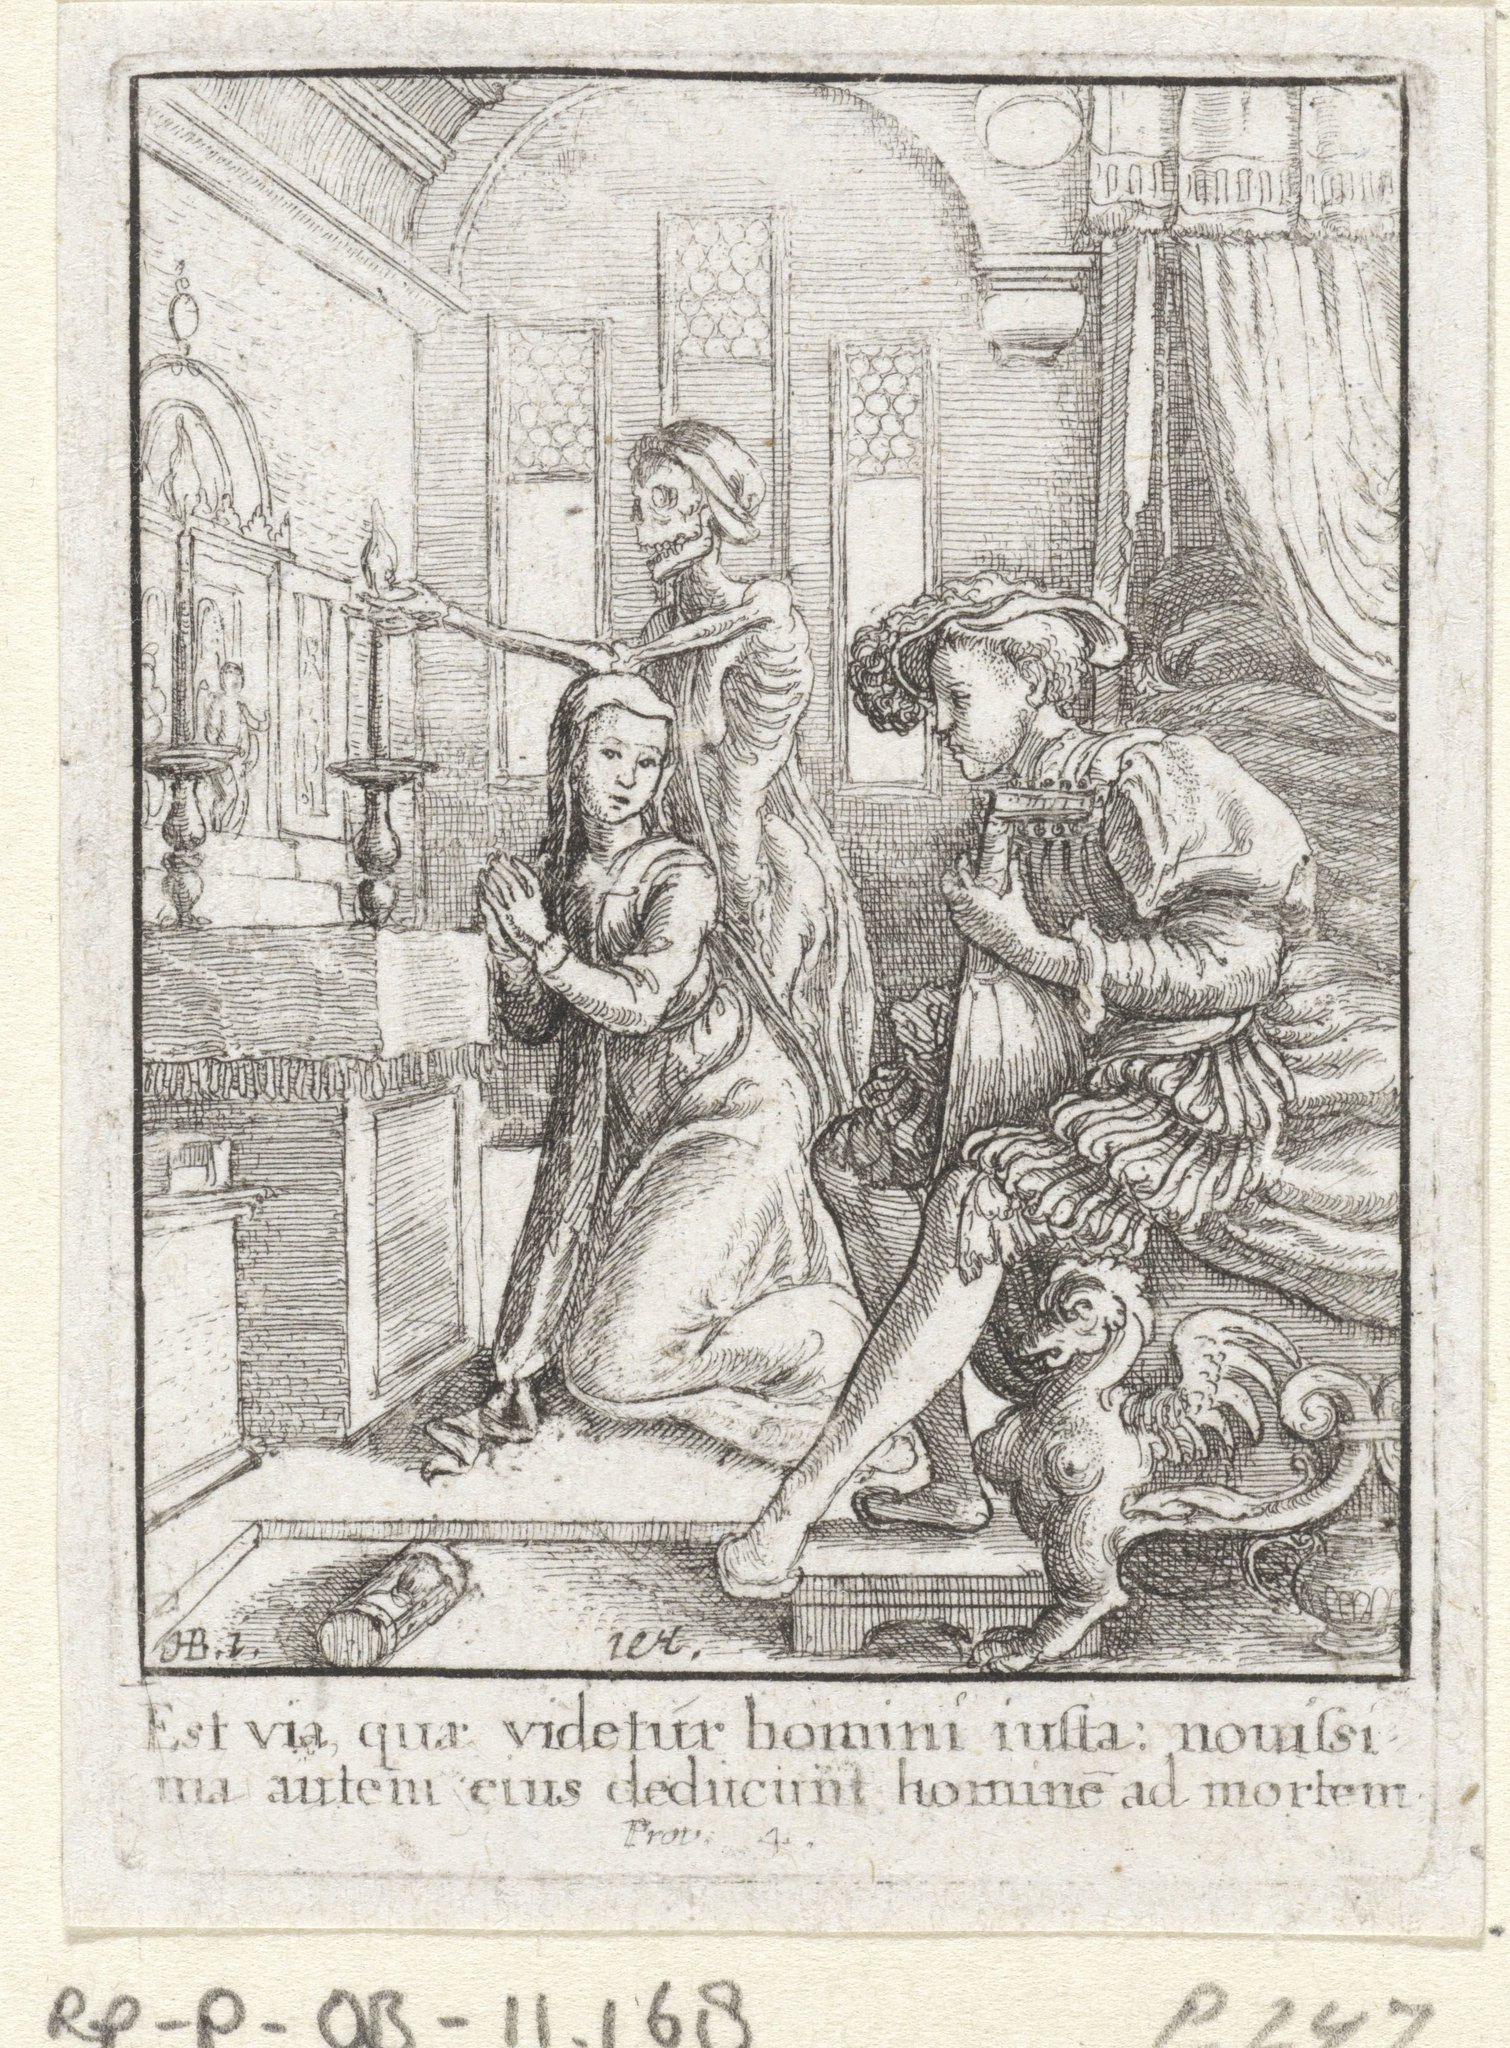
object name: print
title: Dodendans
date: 1680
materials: paper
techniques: etching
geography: antwerp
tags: nun(s), dance of death; death together with one or more human beings, hourglass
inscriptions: collector's mark: Lugt 240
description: Een non knielt voor een altaar en kijkt naar een man die naast haar op een luit speelt. De Dood dooft een kaars op het altaar. Op de grond ligt een omgevallen zandloper.